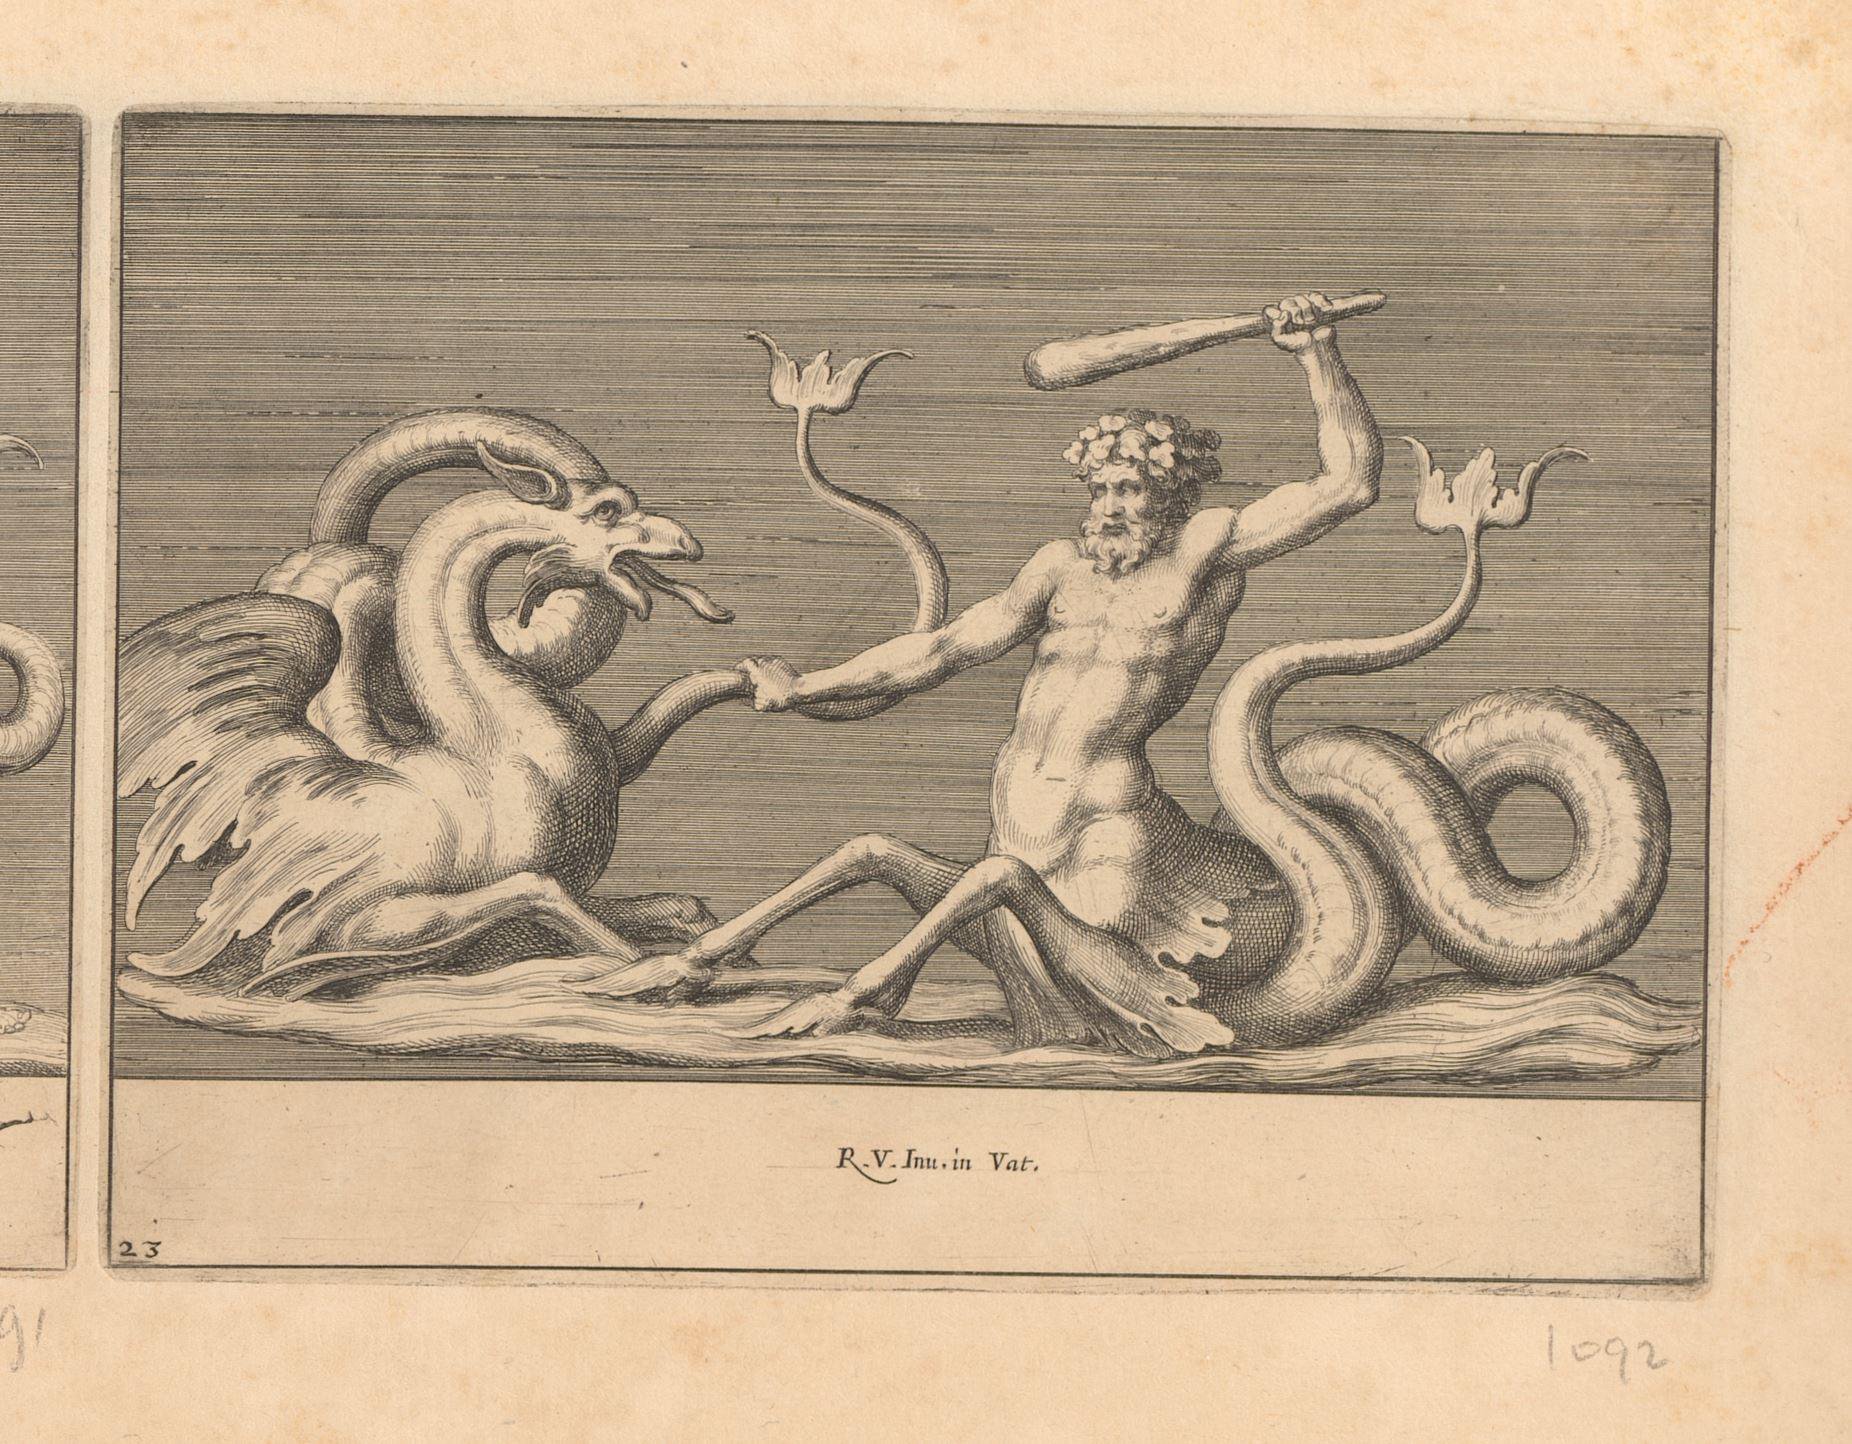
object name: album leaf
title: Reliëfs in de Loggia van Rafaël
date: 1645-1700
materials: paper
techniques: engraving, etching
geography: italy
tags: triton(s), monsters of the sea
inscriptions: number: ‘47’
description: Prent uit een reeks naar de gipsen reliëfs door Rafaël en uitgevoerd door zijn assistenten in de Vaticaanse Loggia.